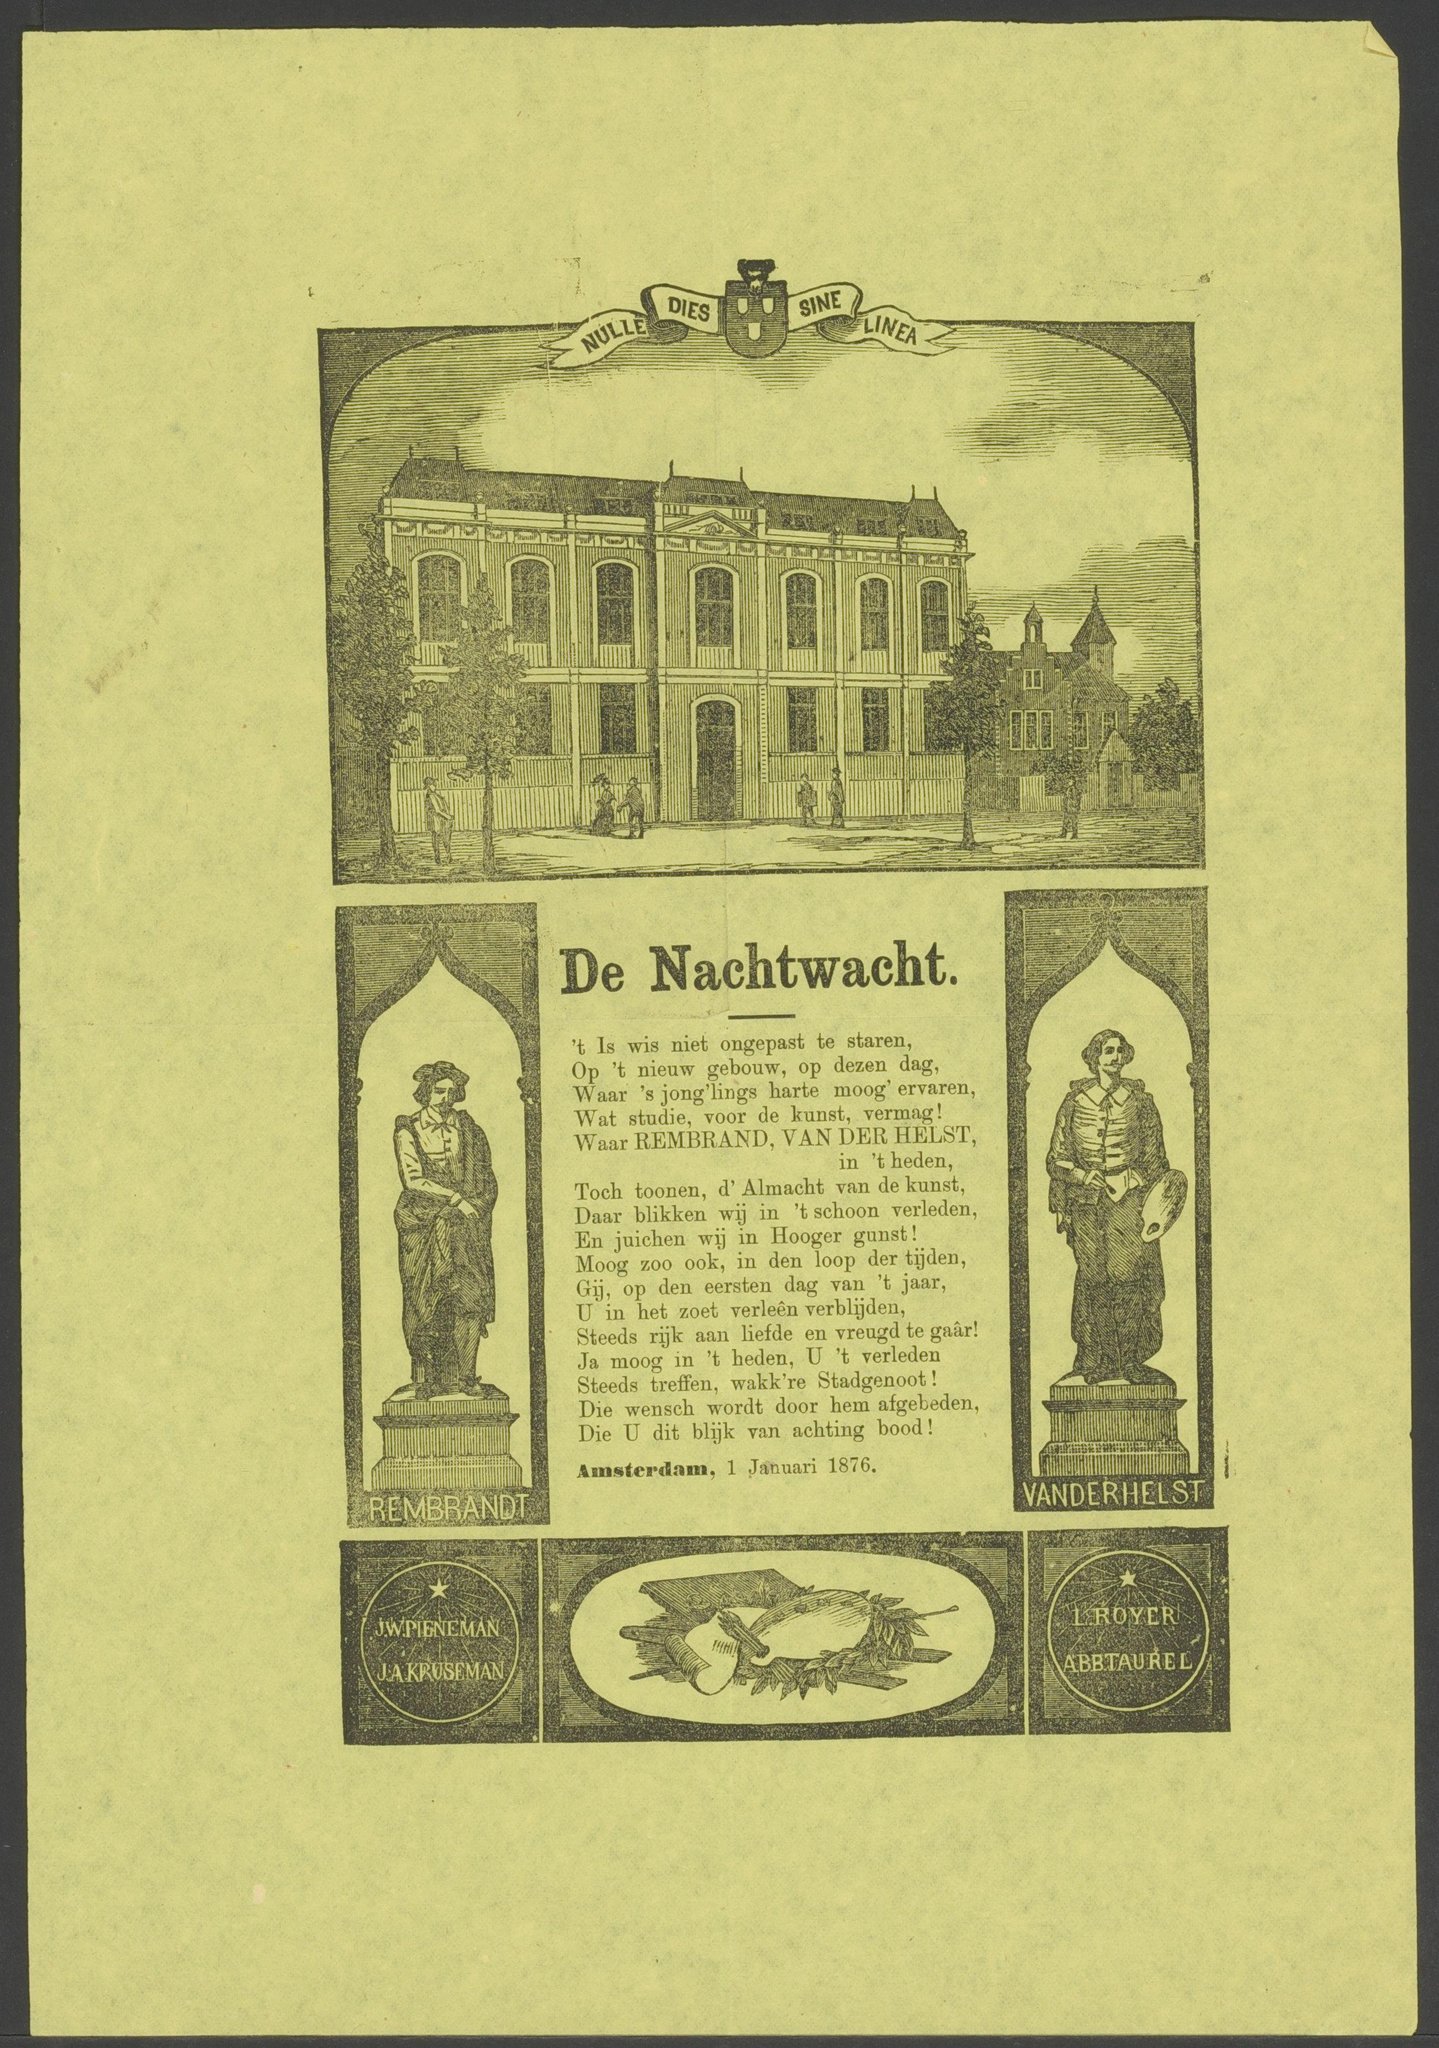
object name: new year card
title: De Nachtwacht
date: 1875-1876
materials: paper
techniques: letterpress printing, engraving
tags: paris, benoit taurel, abcoude, print maker, jan willem pieneman, haarlem, amsterdam, painter, draughtsman, bartholomeus van der helst, jan adam kruseman, mechelen, sculptor, louis royer, leiden, rembrandt van rijn, night patrol, monument, statue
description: Nieuwjaarswens van de Amsterdamse nachtwacht (ratelwacht) voor het jaar 1876. Centraal een gedicht in twee verzen, bovenaan een gezicht het nieuwe gebouw van de Rijksakademie aan de Stadhouderskade. Aan weerszijden van het gedicht afbeeldingen van de standbeelden van Rembrandt (onthuld 1852) en Bartholomeus van der Helst (nooit uitgevoerd). Onderaan vignetten met de namen van J.W. Pieneman, J.A. Kruseman, L. Royer en A.B.B. Taurel. Onderwerpsrubrieken binnen de Atlas Zeden en Gewoonten: Zeden en gewoonten in engeren zin, Volksleven, Volksbladen, Nieuwjaars- en Kerstwenschen, Amsterdam.